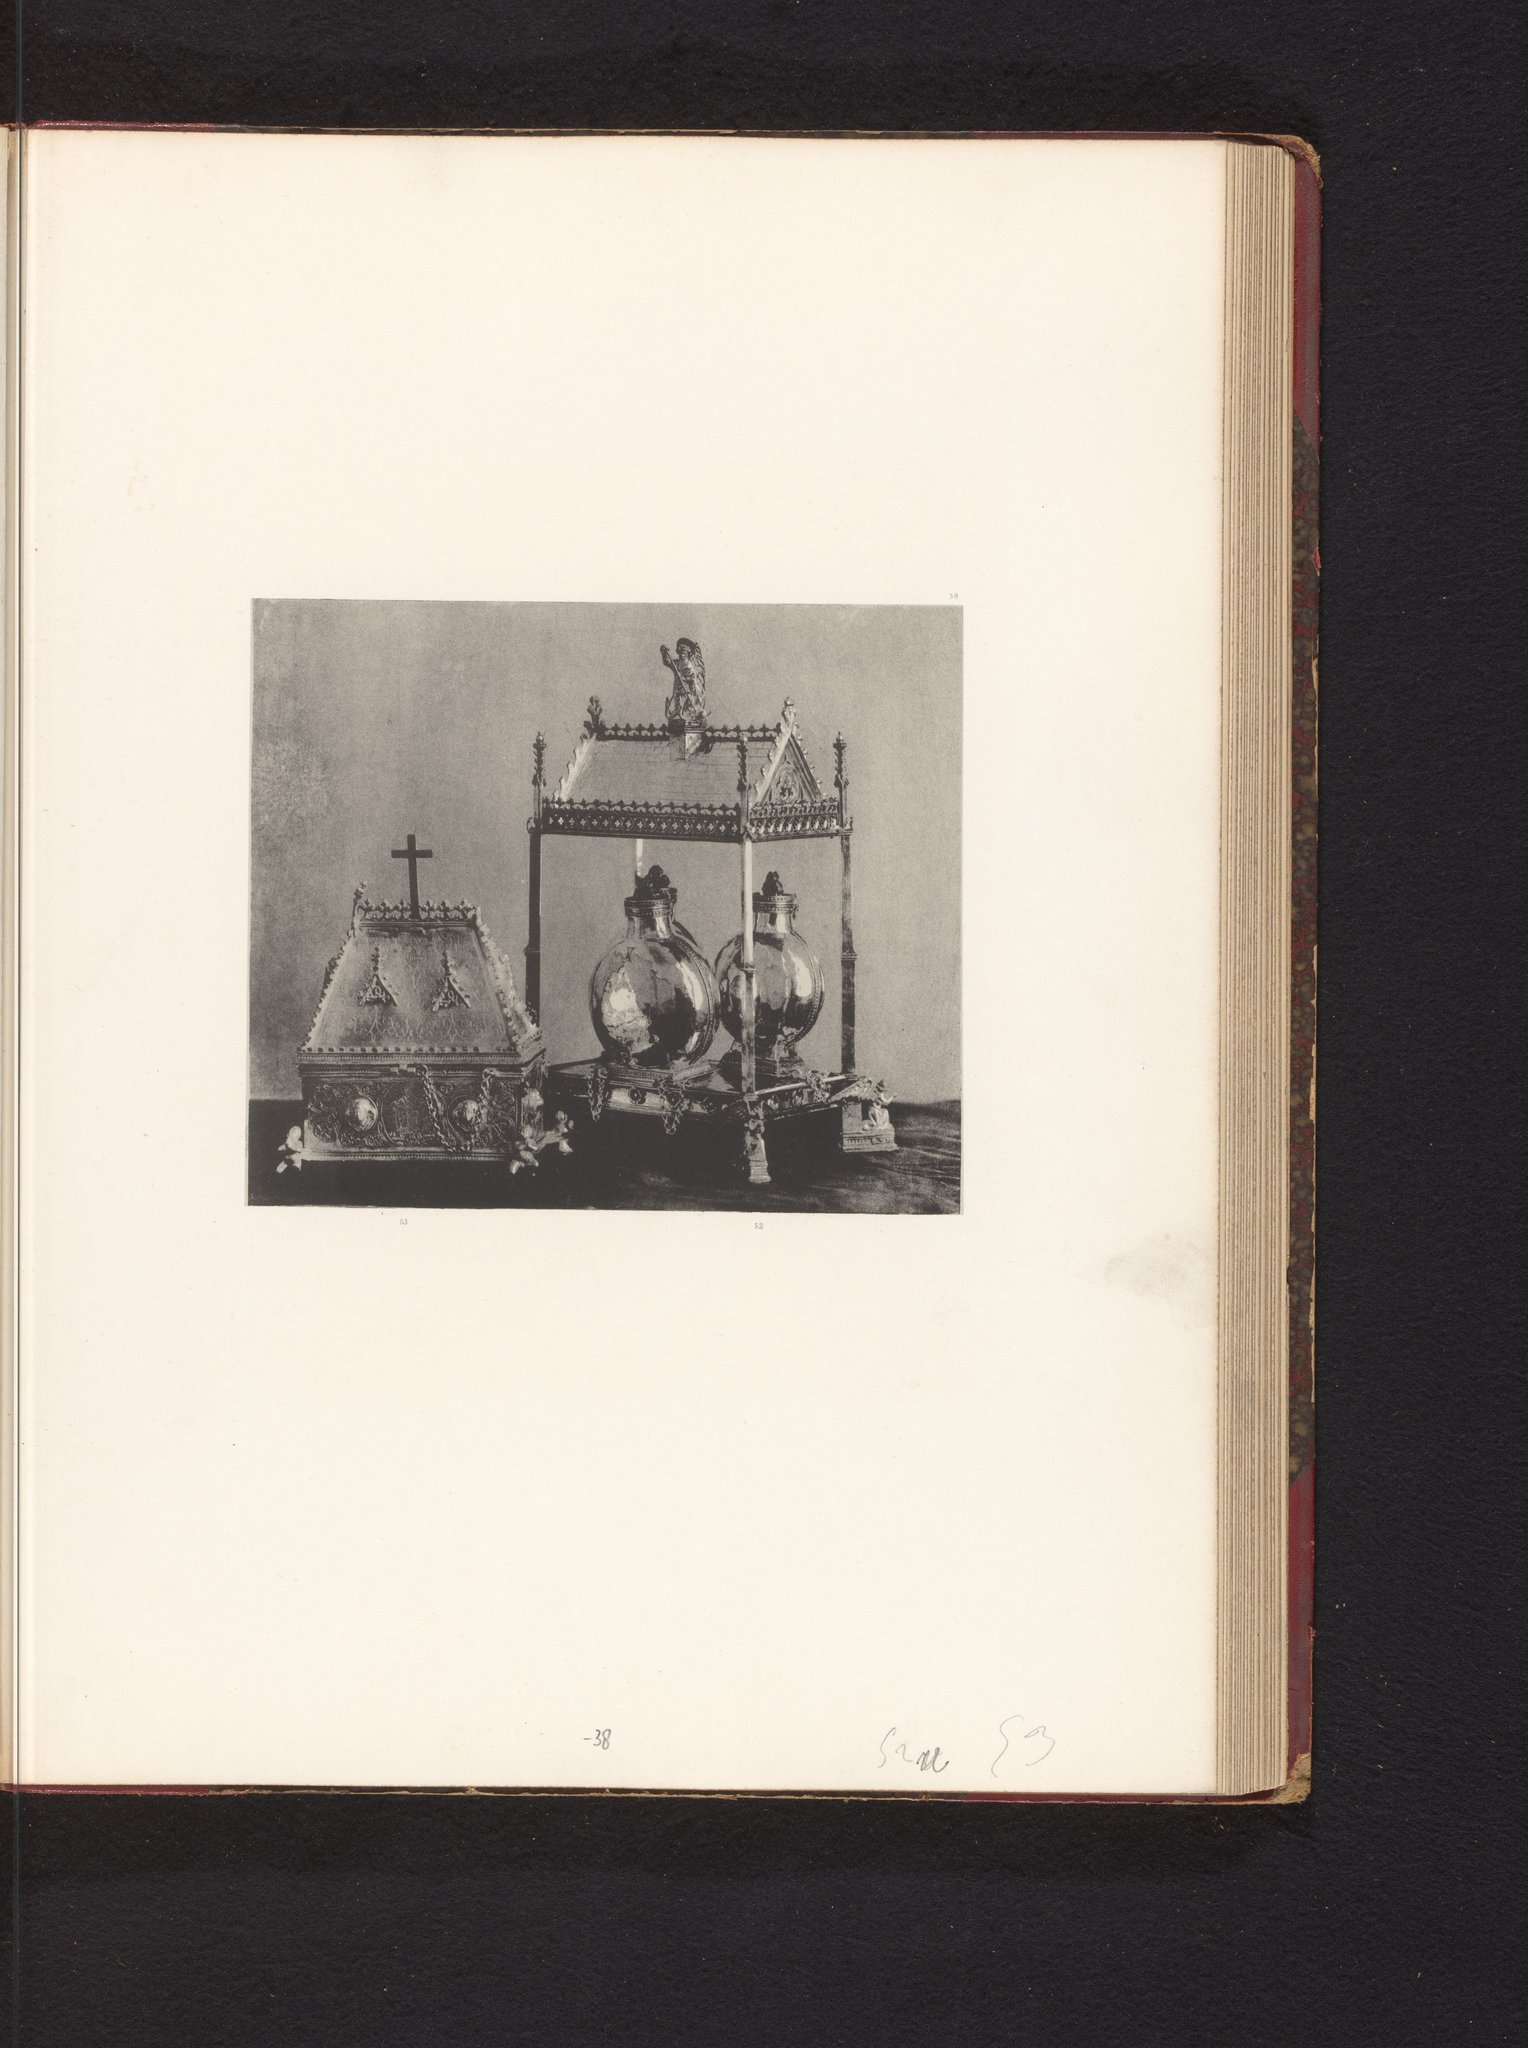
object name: page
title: Twee vergulde zilveren chrismatoria, opgesteld op een tentoonstelling over religieuze objecten uit de middeleeuwen en renaissance in 1864 in Mechelen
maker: joseph maes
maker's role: fotograaf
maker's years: 1838-1908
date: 1864-1866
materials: paper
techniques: photolithography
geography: mechelen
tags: oil used in the church, vessels and utensils used in the church, mechelen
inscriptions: number: ‘52 u 53’, number: ‘-38’, number: ‘53 - 52’